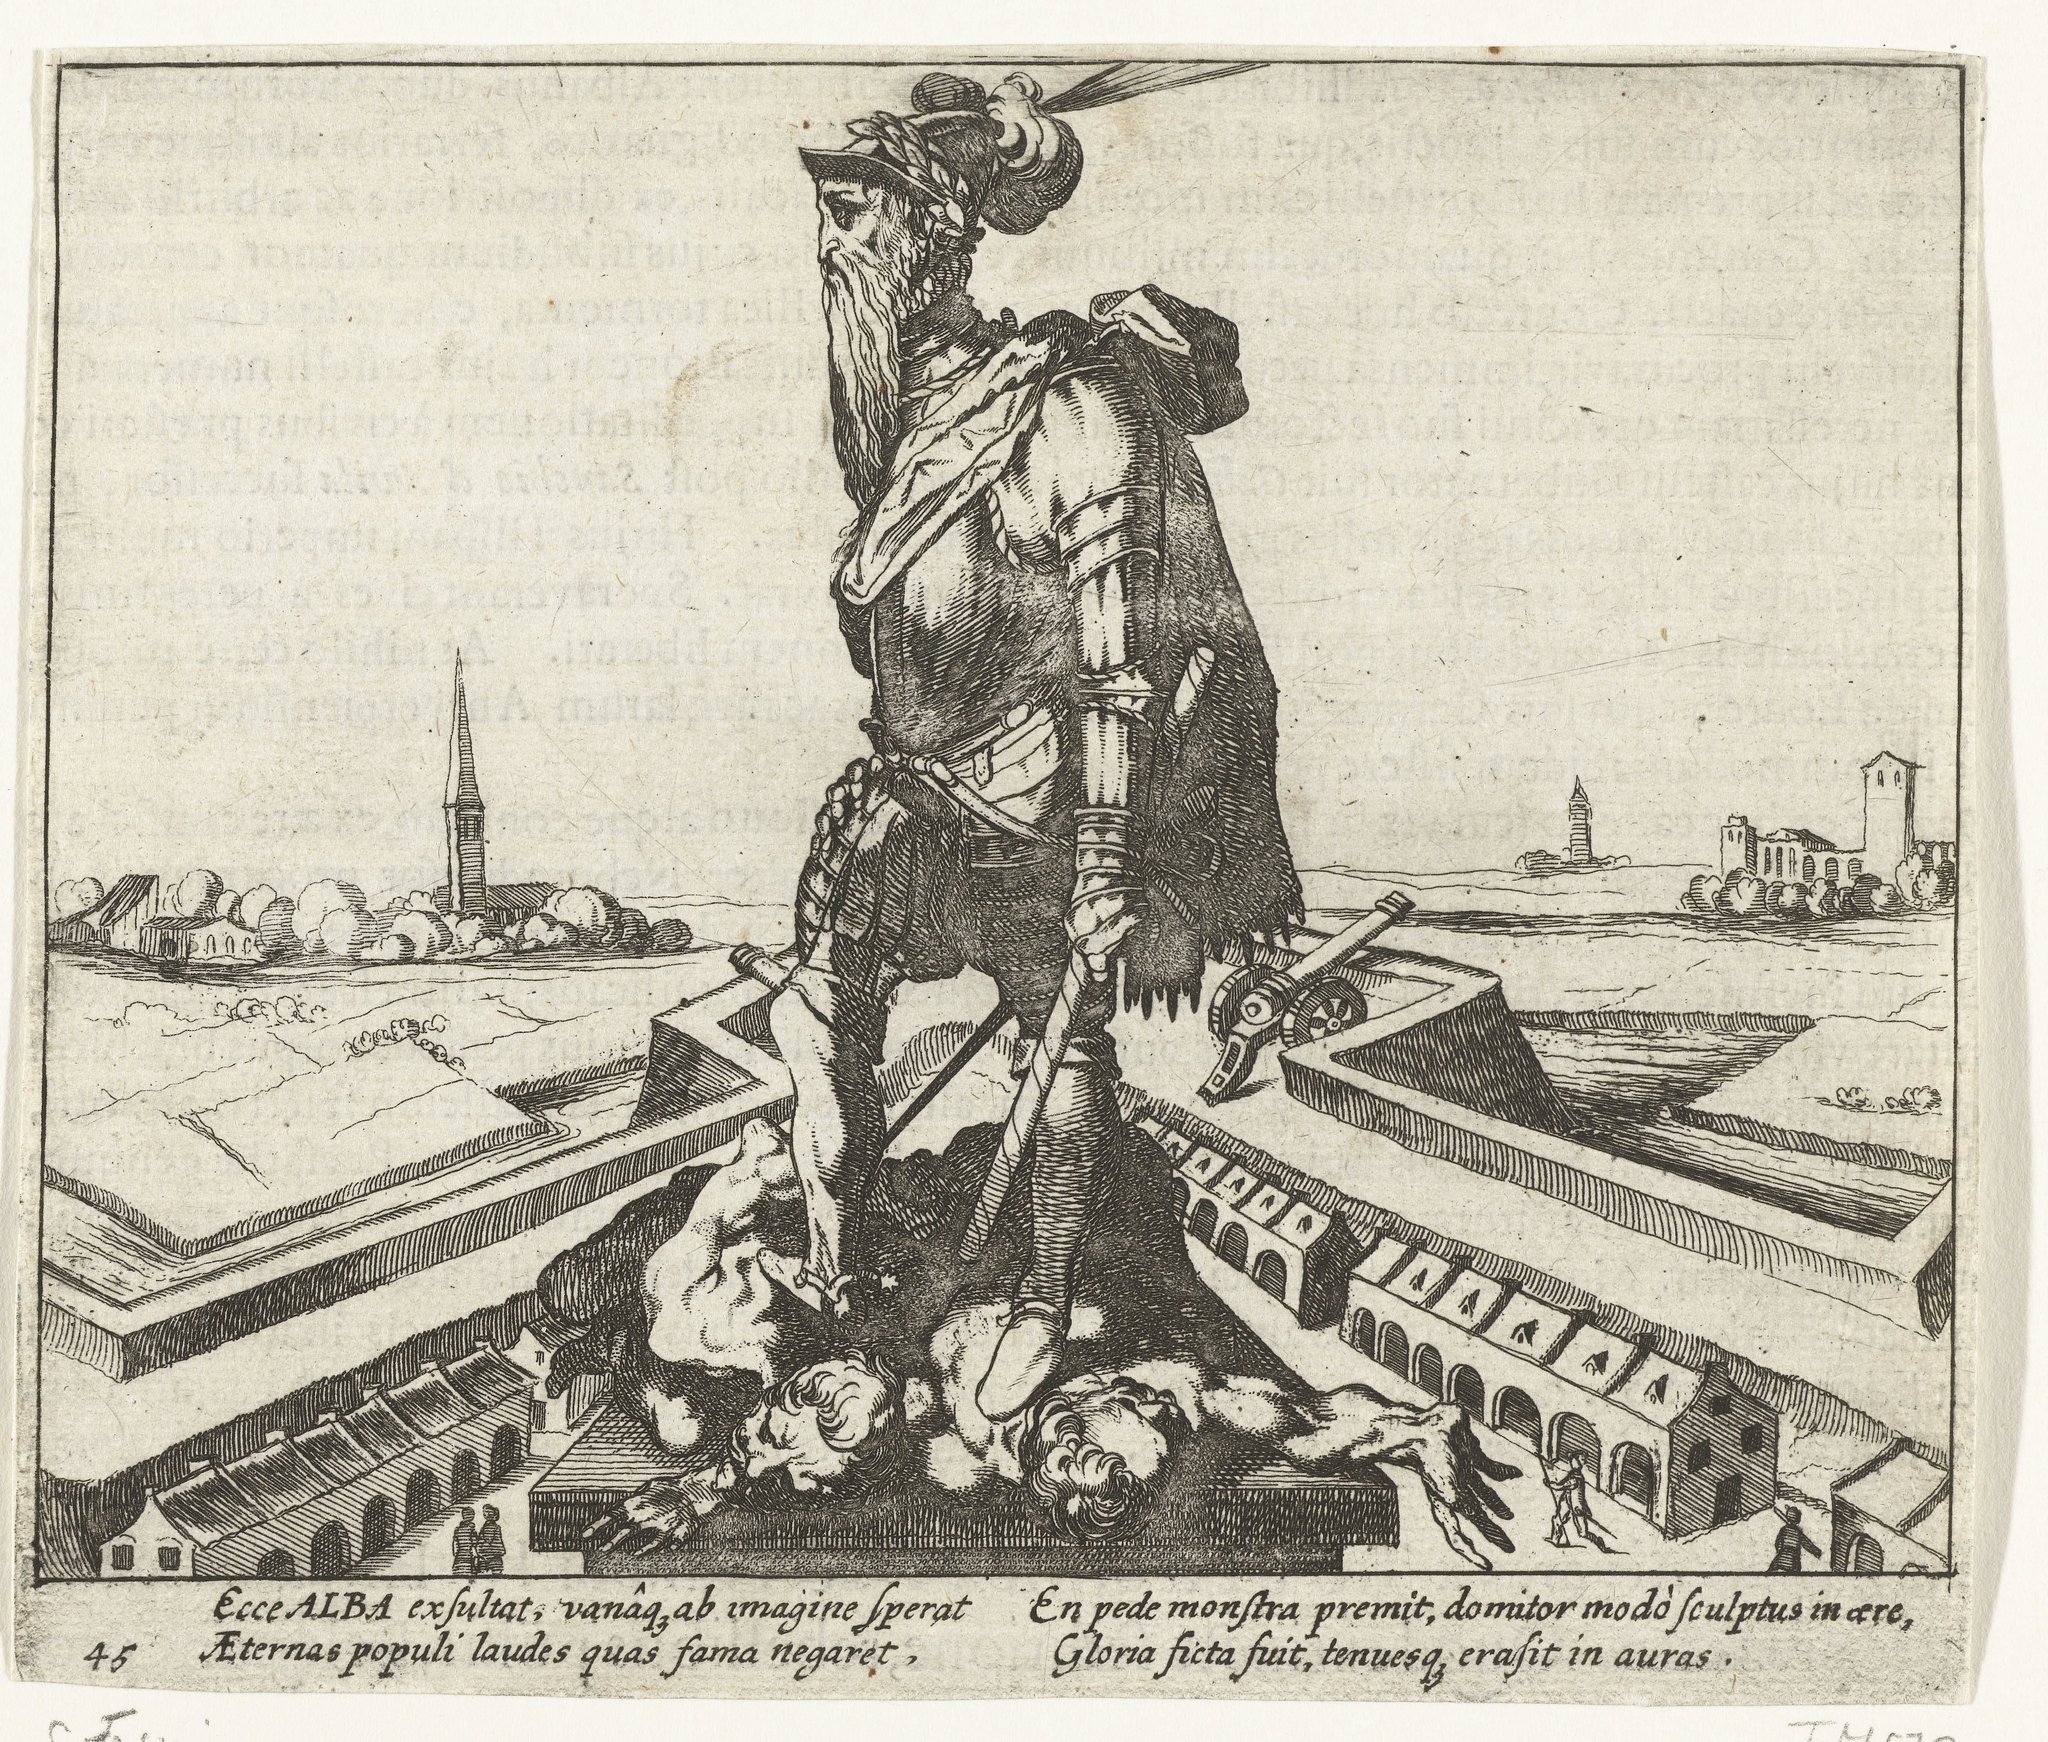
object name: print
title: Standbeeld van de hertog van Alva, 1571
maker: simon frisius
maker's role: print maker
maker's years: 1570-1628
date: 1613-1615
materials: paper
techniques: etching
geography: northern netherlands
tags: fernando álvarez de toledo (3rd duke of alba), piece of sculpture, reproduction of a piece of sculpture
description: Het standbeeld van de hertog van Alva, door hemzelf opgericht op de binnenplaats van de citadel te Antwerpen, 1571. Karikaturale voorstelling van het beeld met een deel van het kasteel en het buitenliggend landschap. Met onderschrift van 4 regels in het Latijn. Genummerd: 45. Bedrukt op achterzijde met tekst in het Latijn.